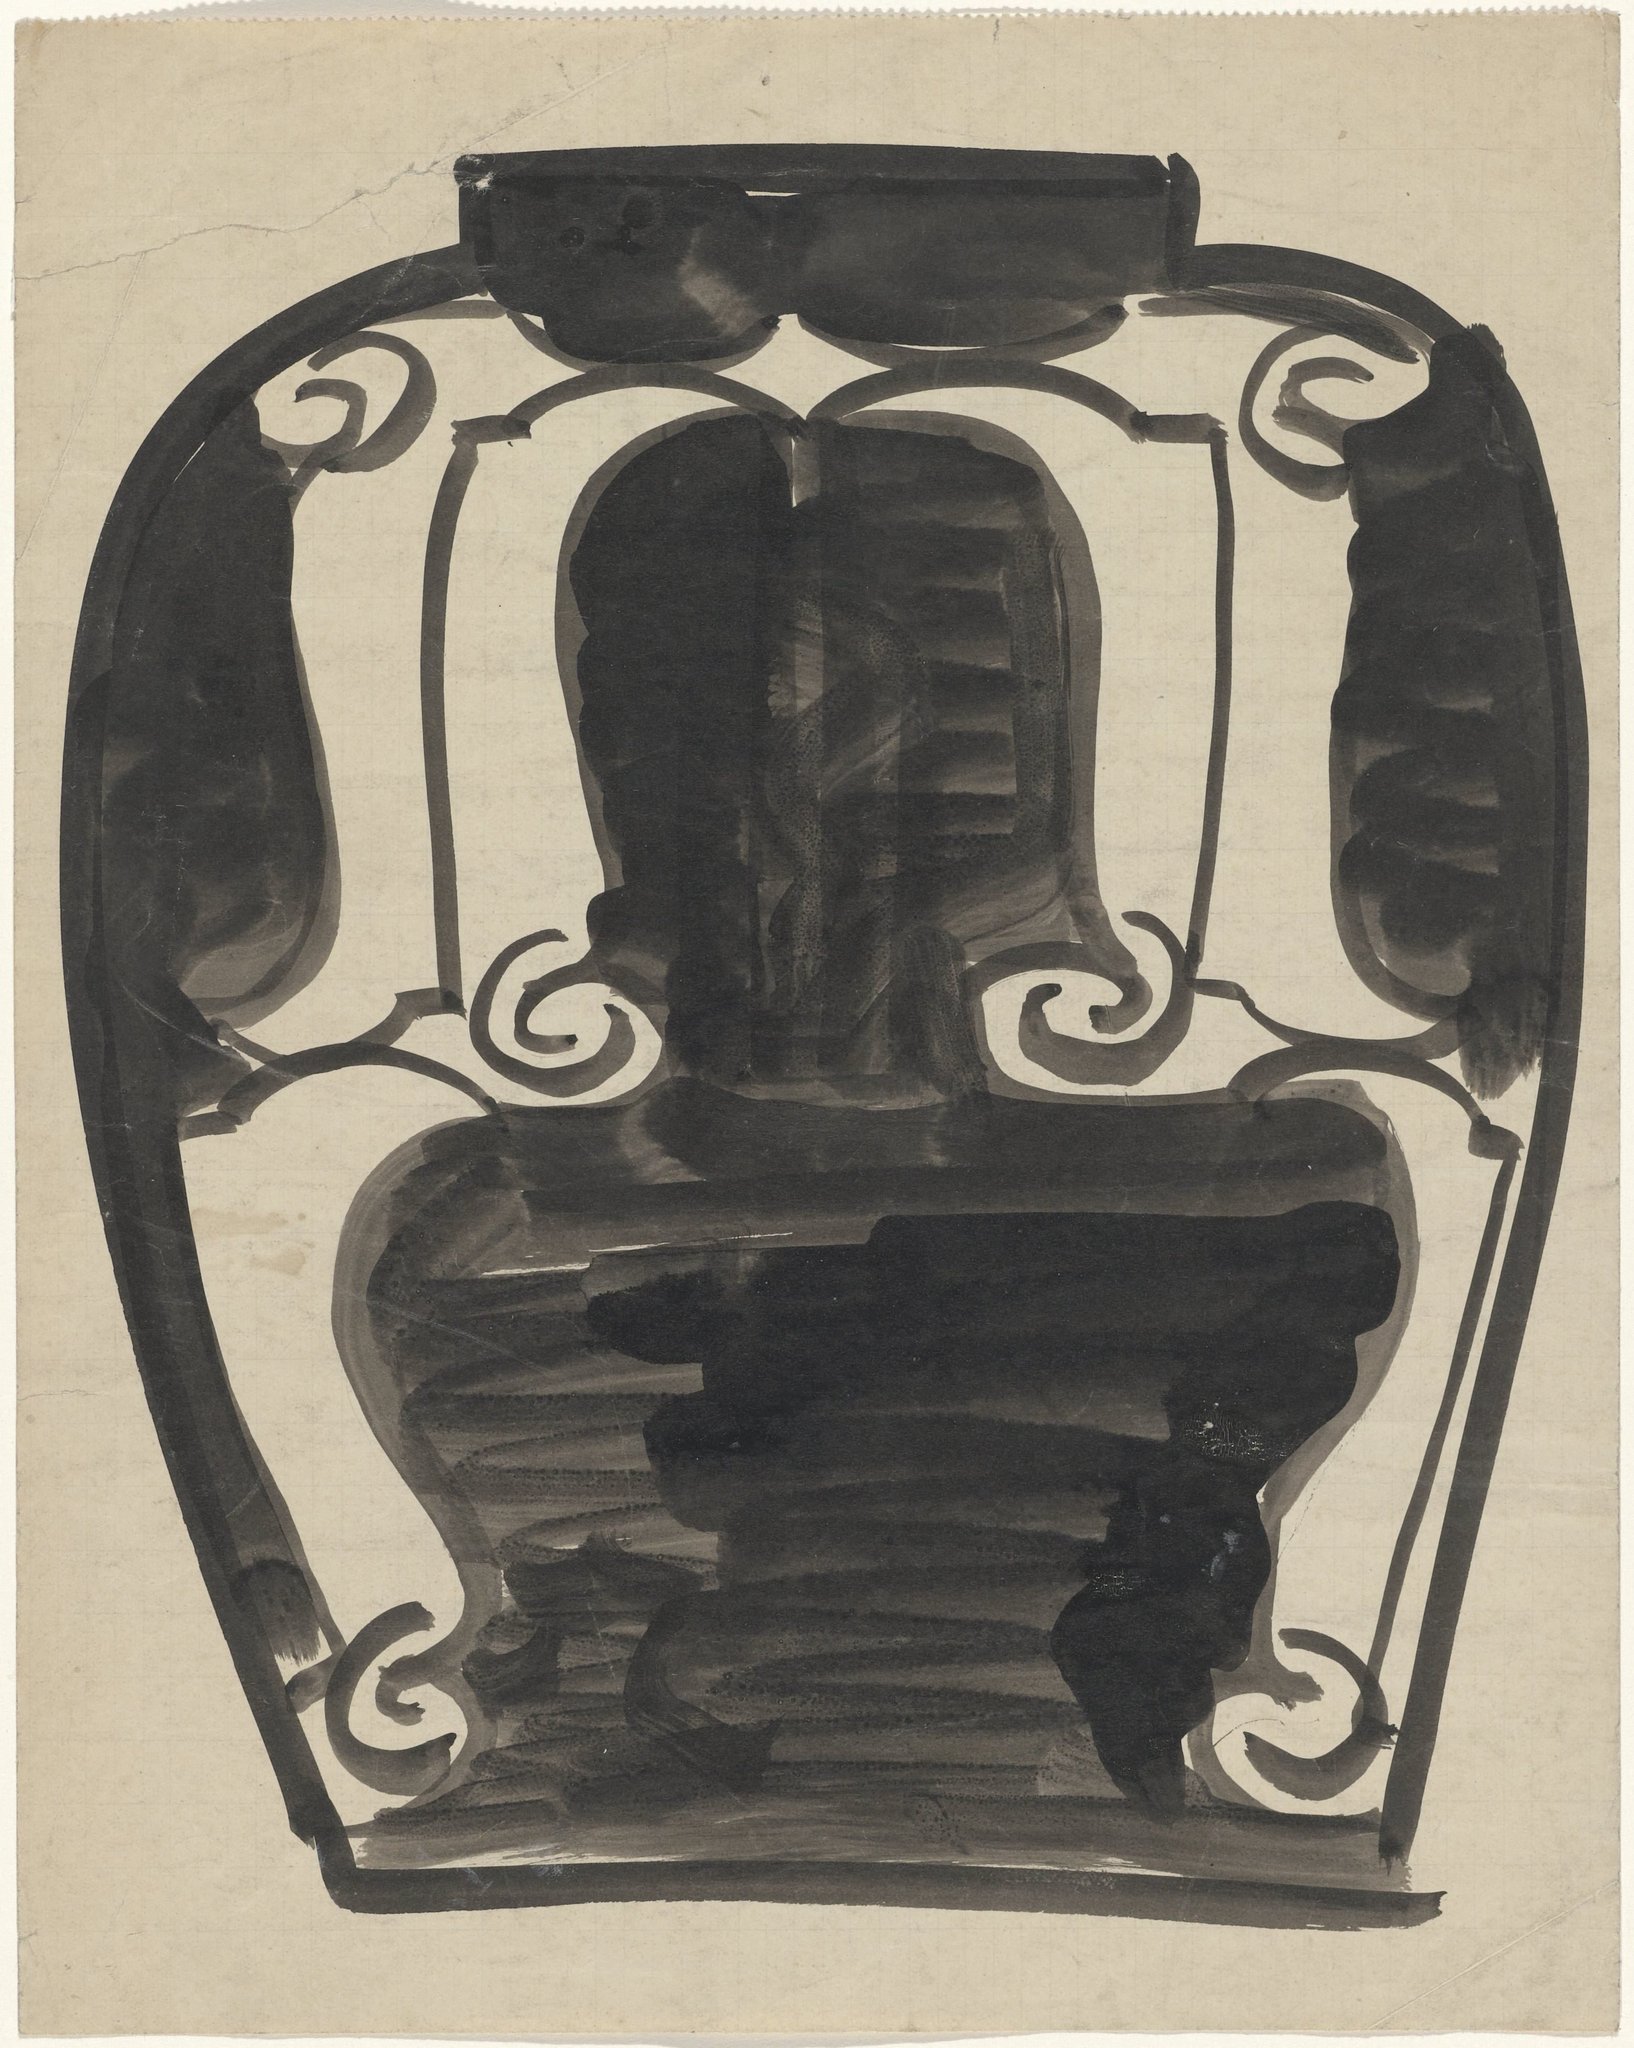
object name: design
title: Ontwerp voor een vaas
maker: carel adolph lion cachet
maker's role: draughtsman, print maker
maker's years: 1864-1945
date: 1874-1945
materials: squared paper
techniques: brush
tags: work of applied art (+ ceramics ~ arts), container of ceramics: jar, jug, pot, vase